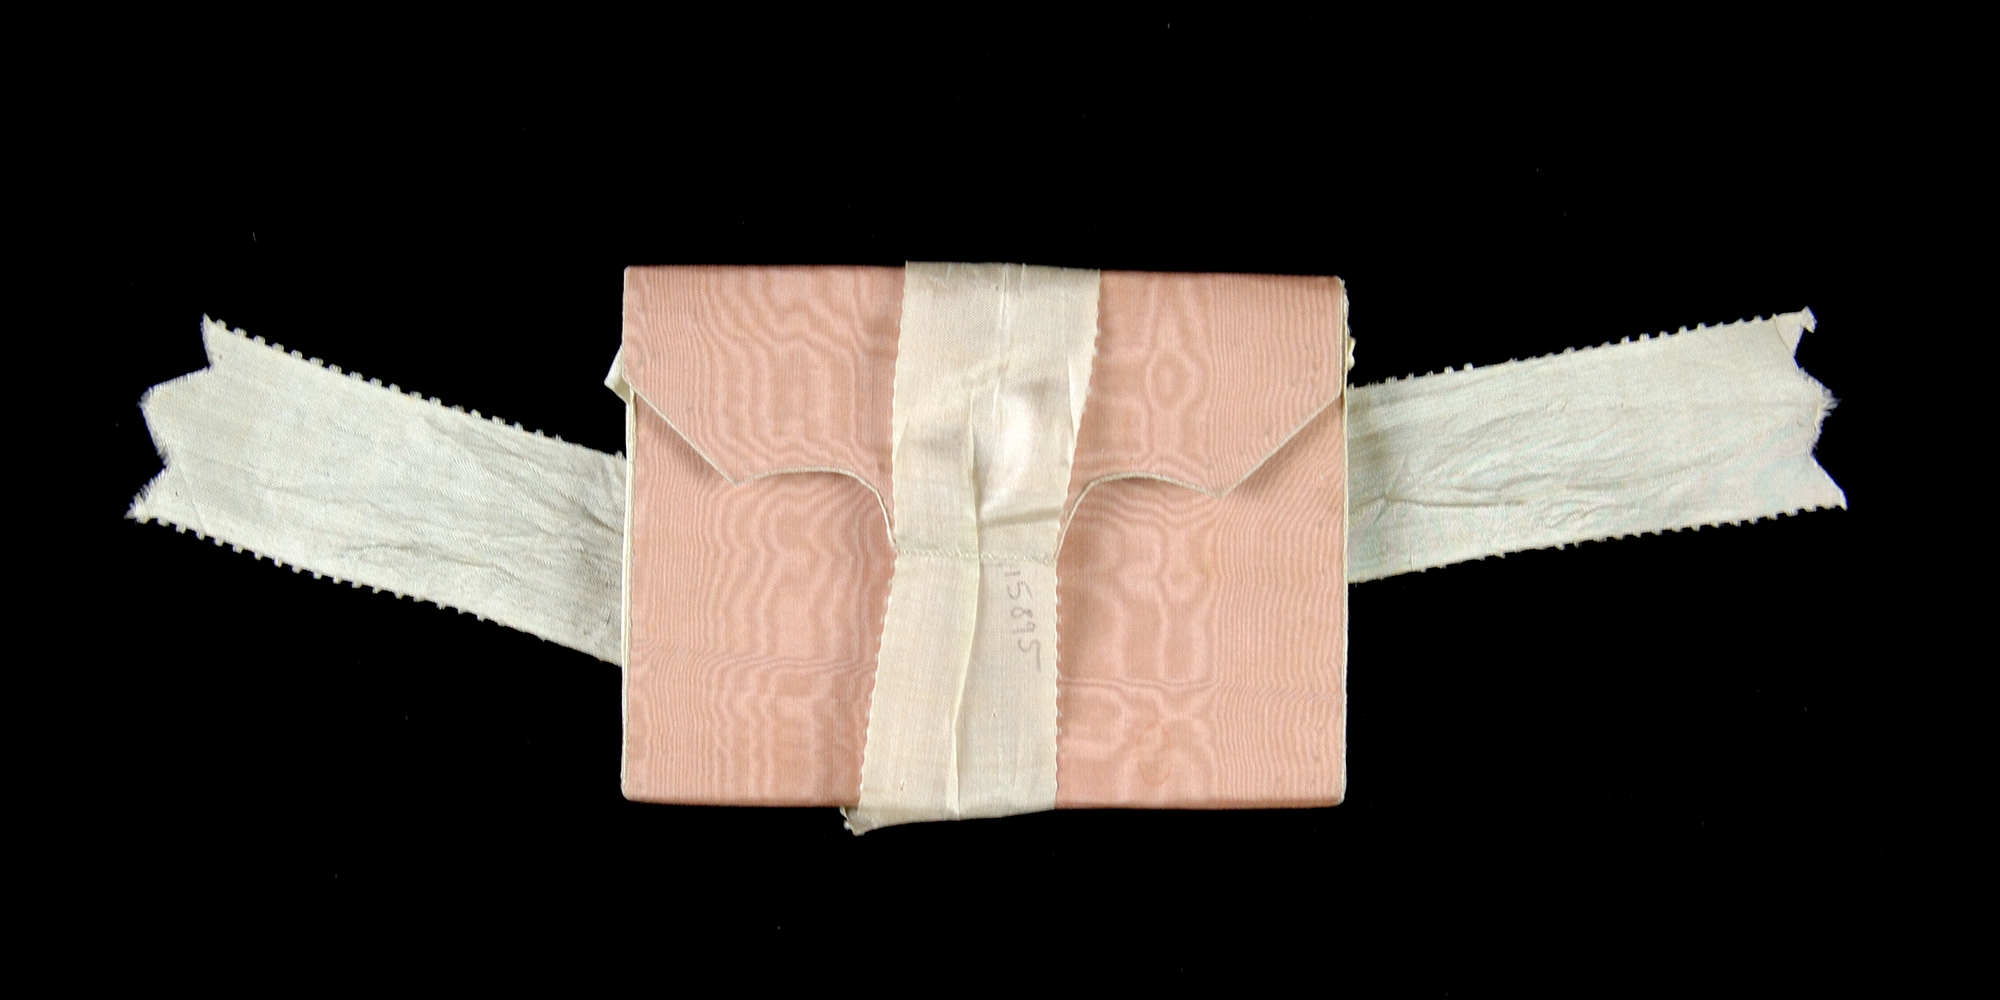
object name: wallet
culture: american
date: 1790-1810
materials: silk